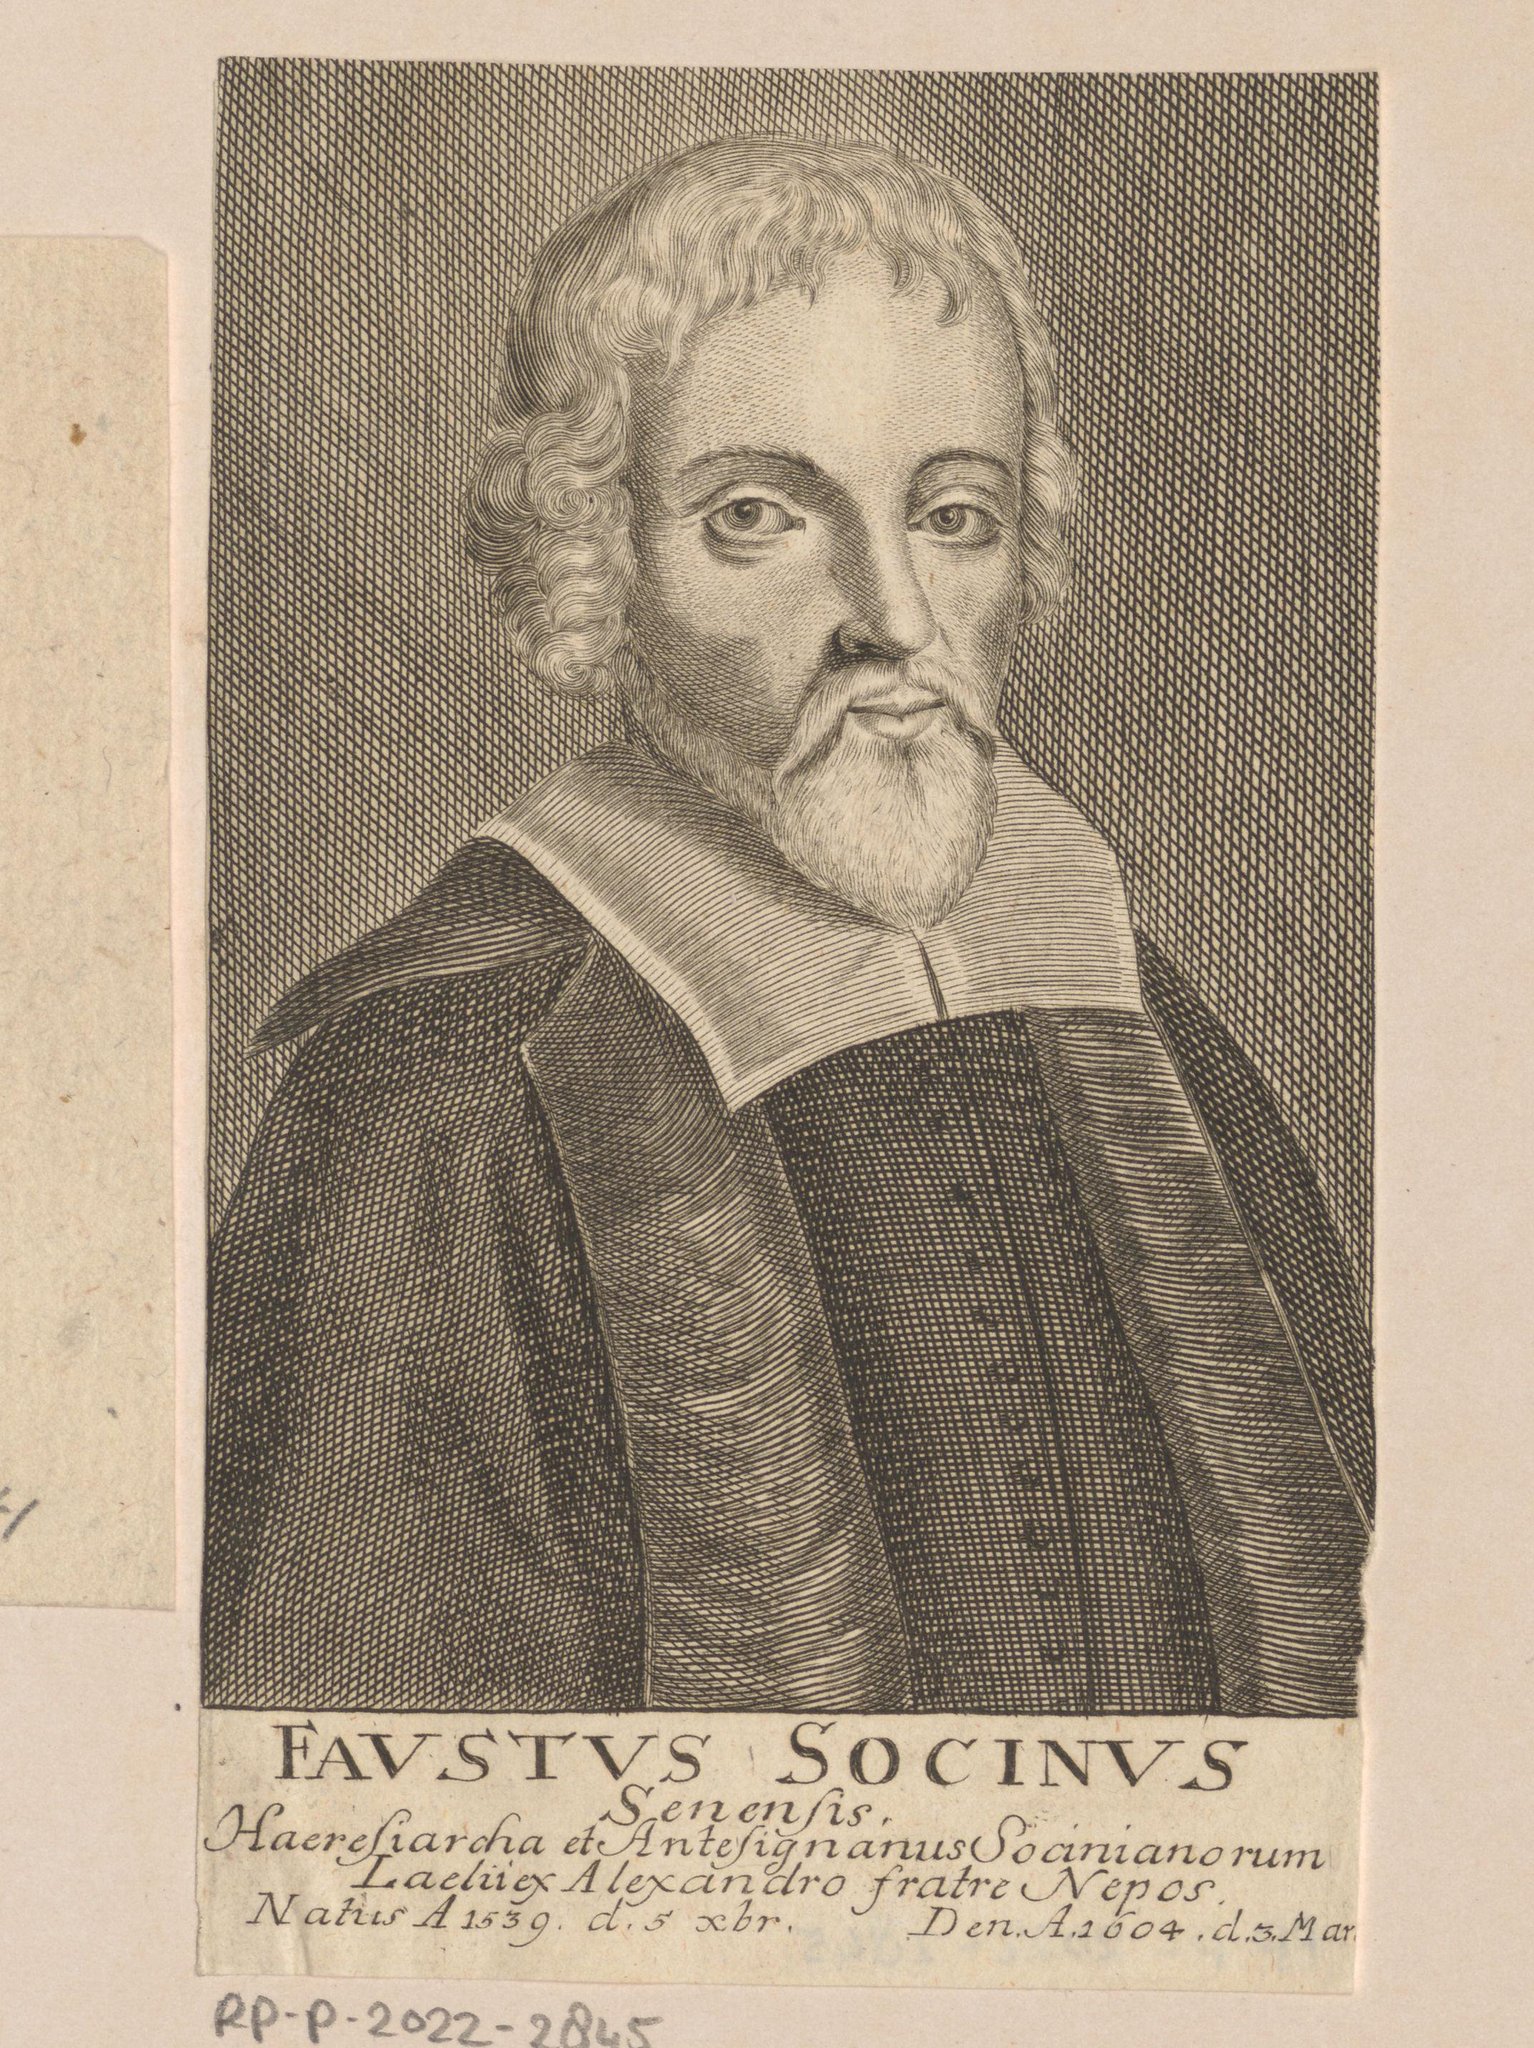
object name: print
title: Portret van Faustus Socinus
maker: Anonymous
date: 1604-1750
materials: paper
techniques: engraving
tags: theologian, historical persons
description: Met vierregelig onderschrift in het Latijn.